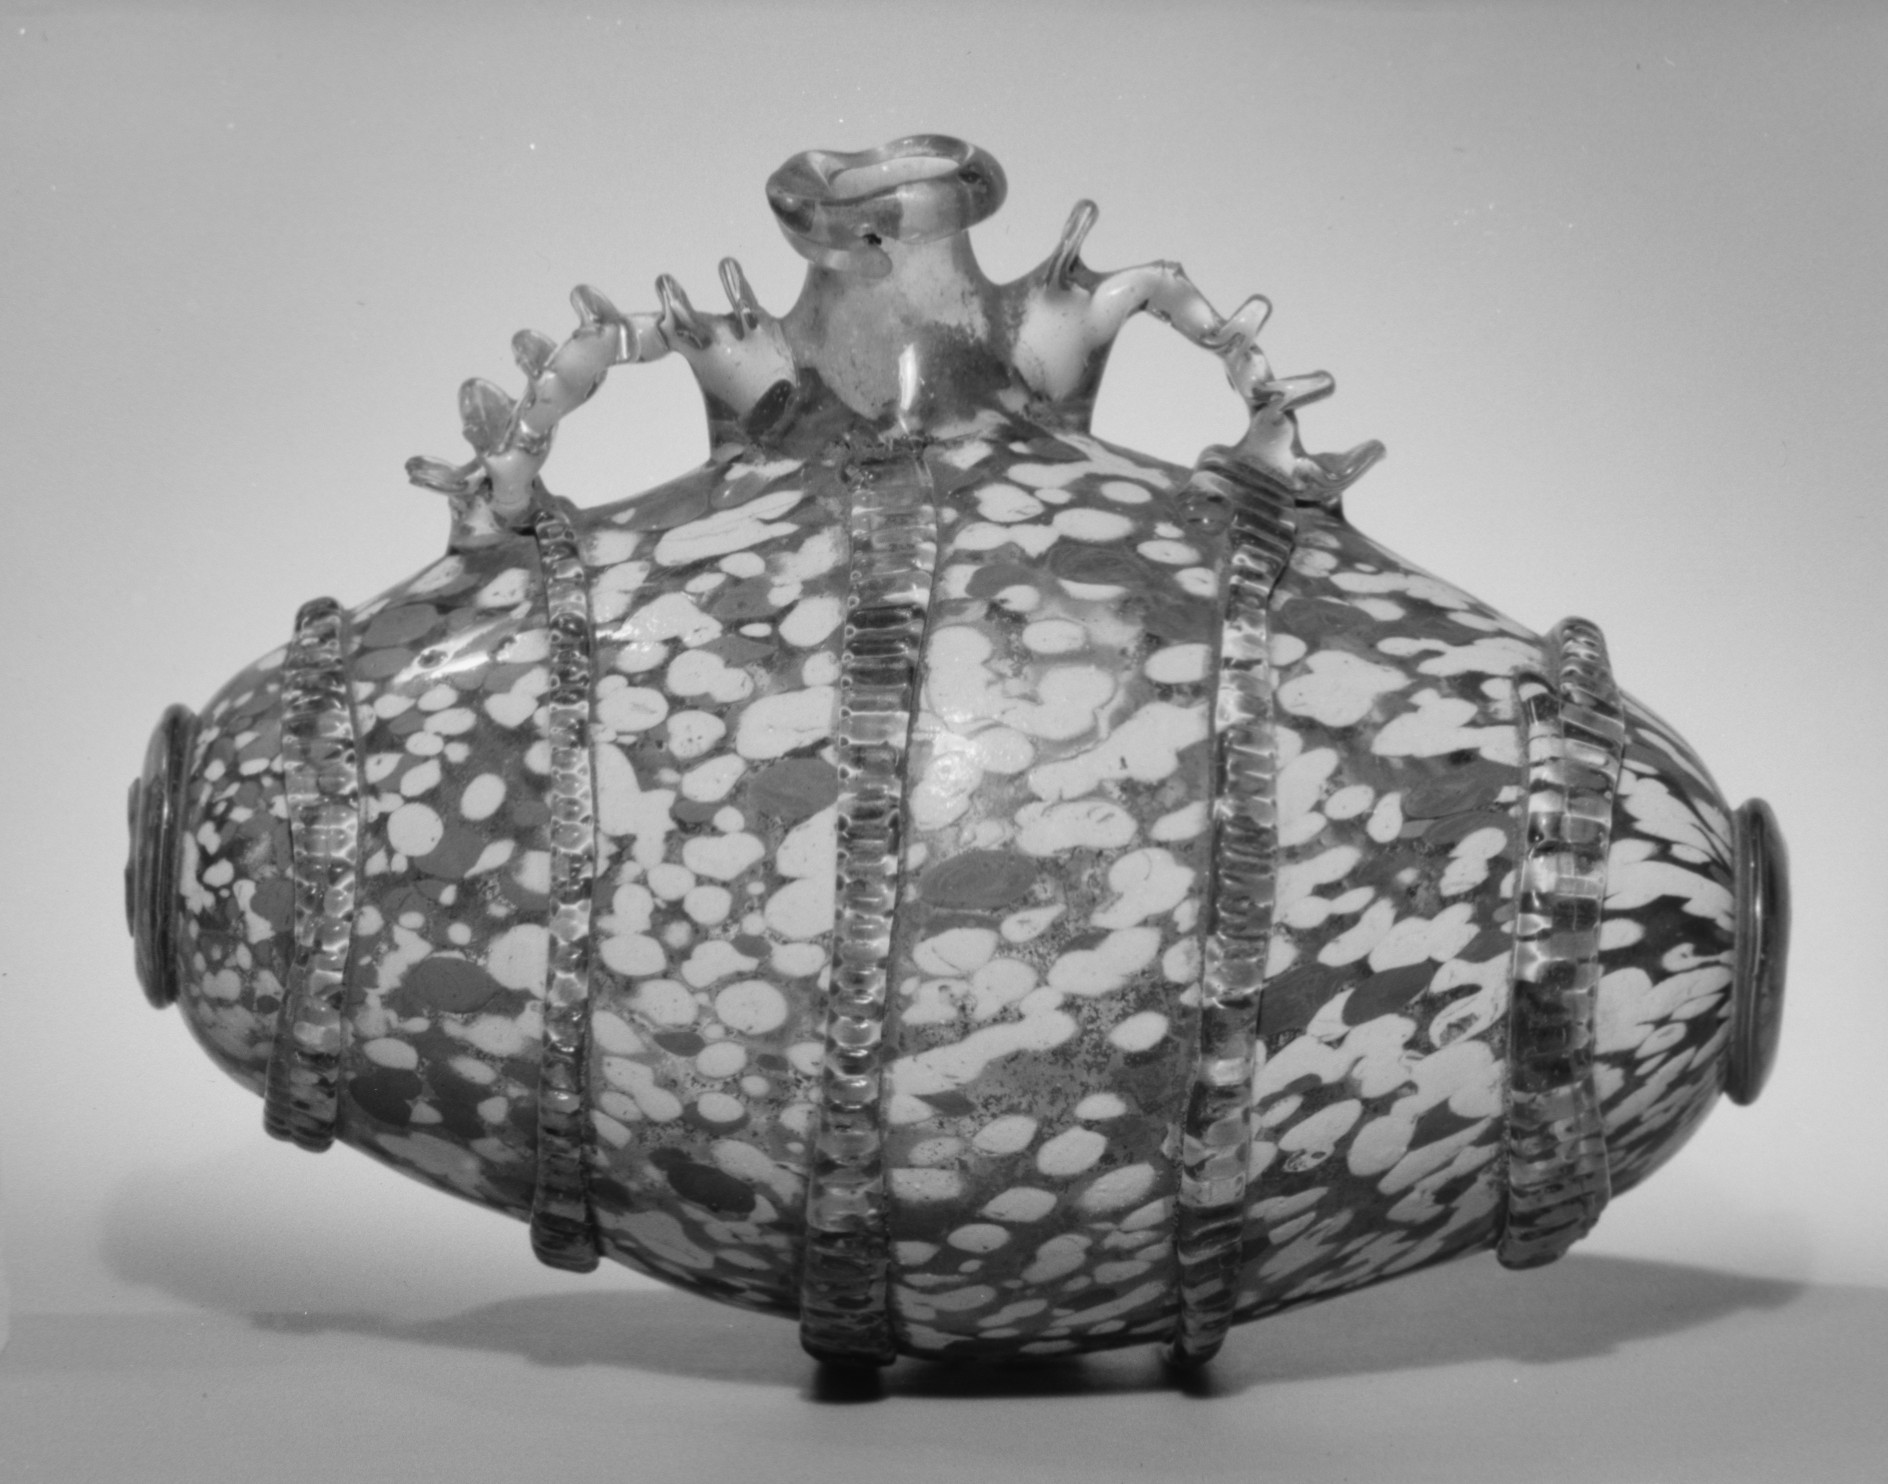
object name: flask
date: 1601-1700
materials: glass